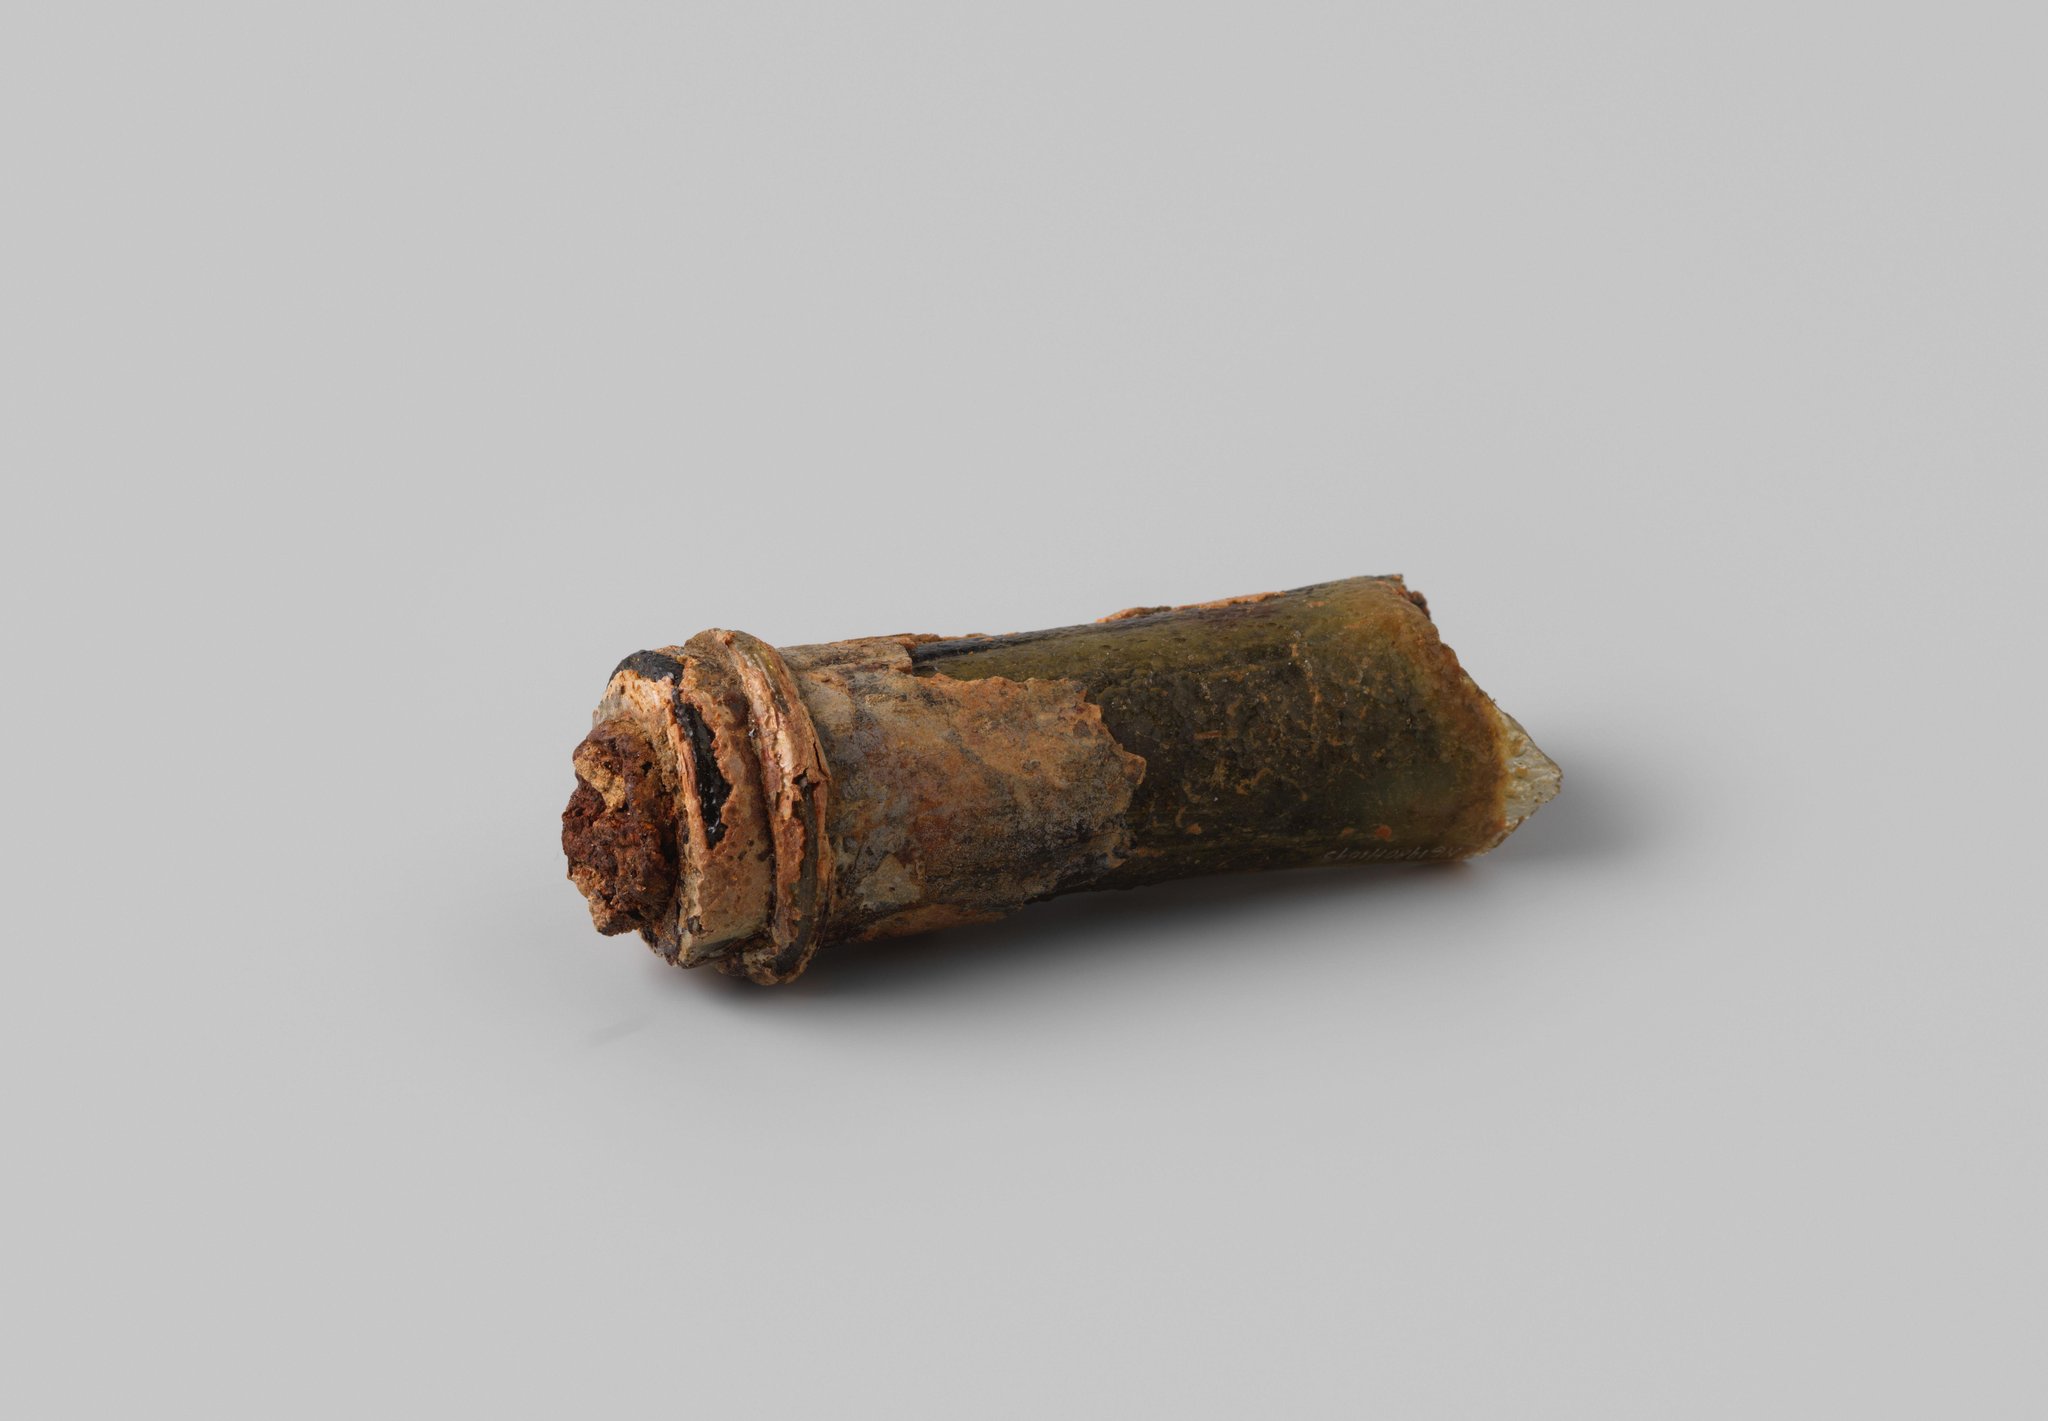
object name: sherd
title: Hals met kurk van een wijnfles uit het wrak van de Oost-Indiëvaarder Hollandia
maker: Anonymous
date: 1700-1743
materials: glass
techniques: green glass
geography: netherlands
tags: verenigde oostindische compagnie, hollandia (schip), annet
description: Wine bottle, continental production, with straight neck and cylindrical body, fragm, vs-string rim, with cork, projecting.